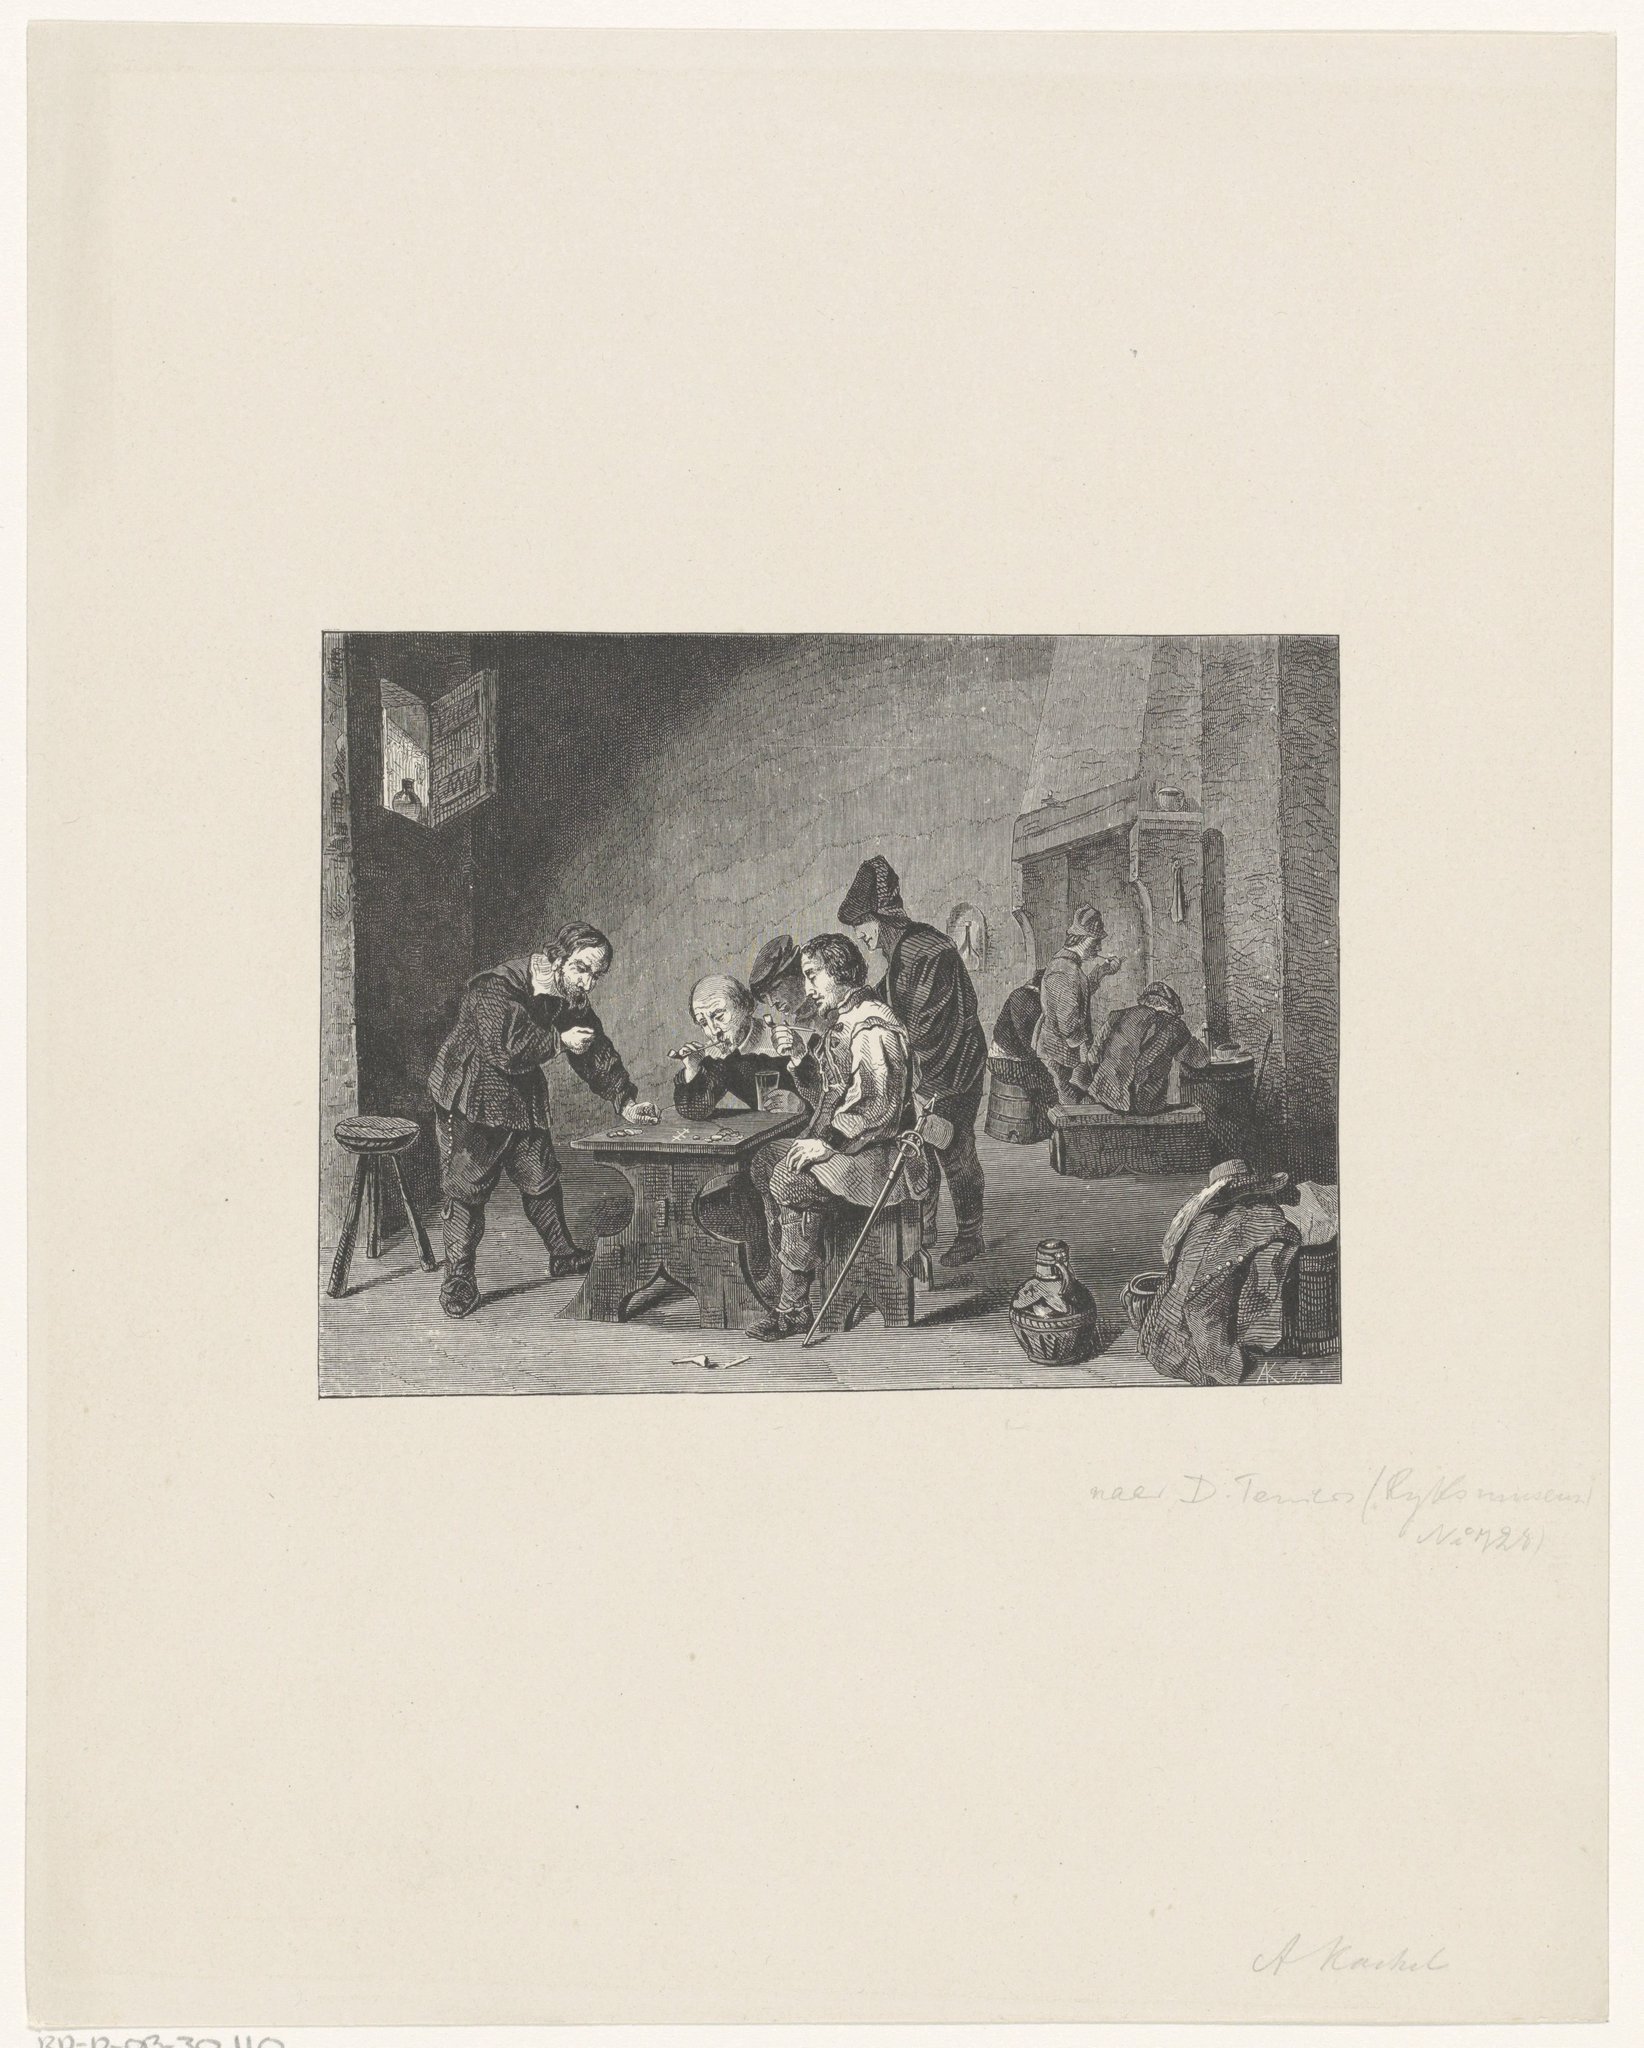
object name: print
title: Dobbelaars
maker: a. kachel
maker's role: print maker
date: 1800-1899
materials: paper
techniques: engraving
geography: netherlands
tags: pipe ~ tobacco, open hearth, fire-place, coin, dice-games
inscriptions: collector's mark: Lugt 2228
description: Herberginterieur met een groepje mannen rond een tafel verwikkeld in een dobbelspel. Op tafel liggen stapels geldstukken, op de achtergrond zit een groepje boeren bij de haard. Op de voorgrond rechts liggen een jas en een hoed met pluim op een kruk en staat een kruik op de vloer.